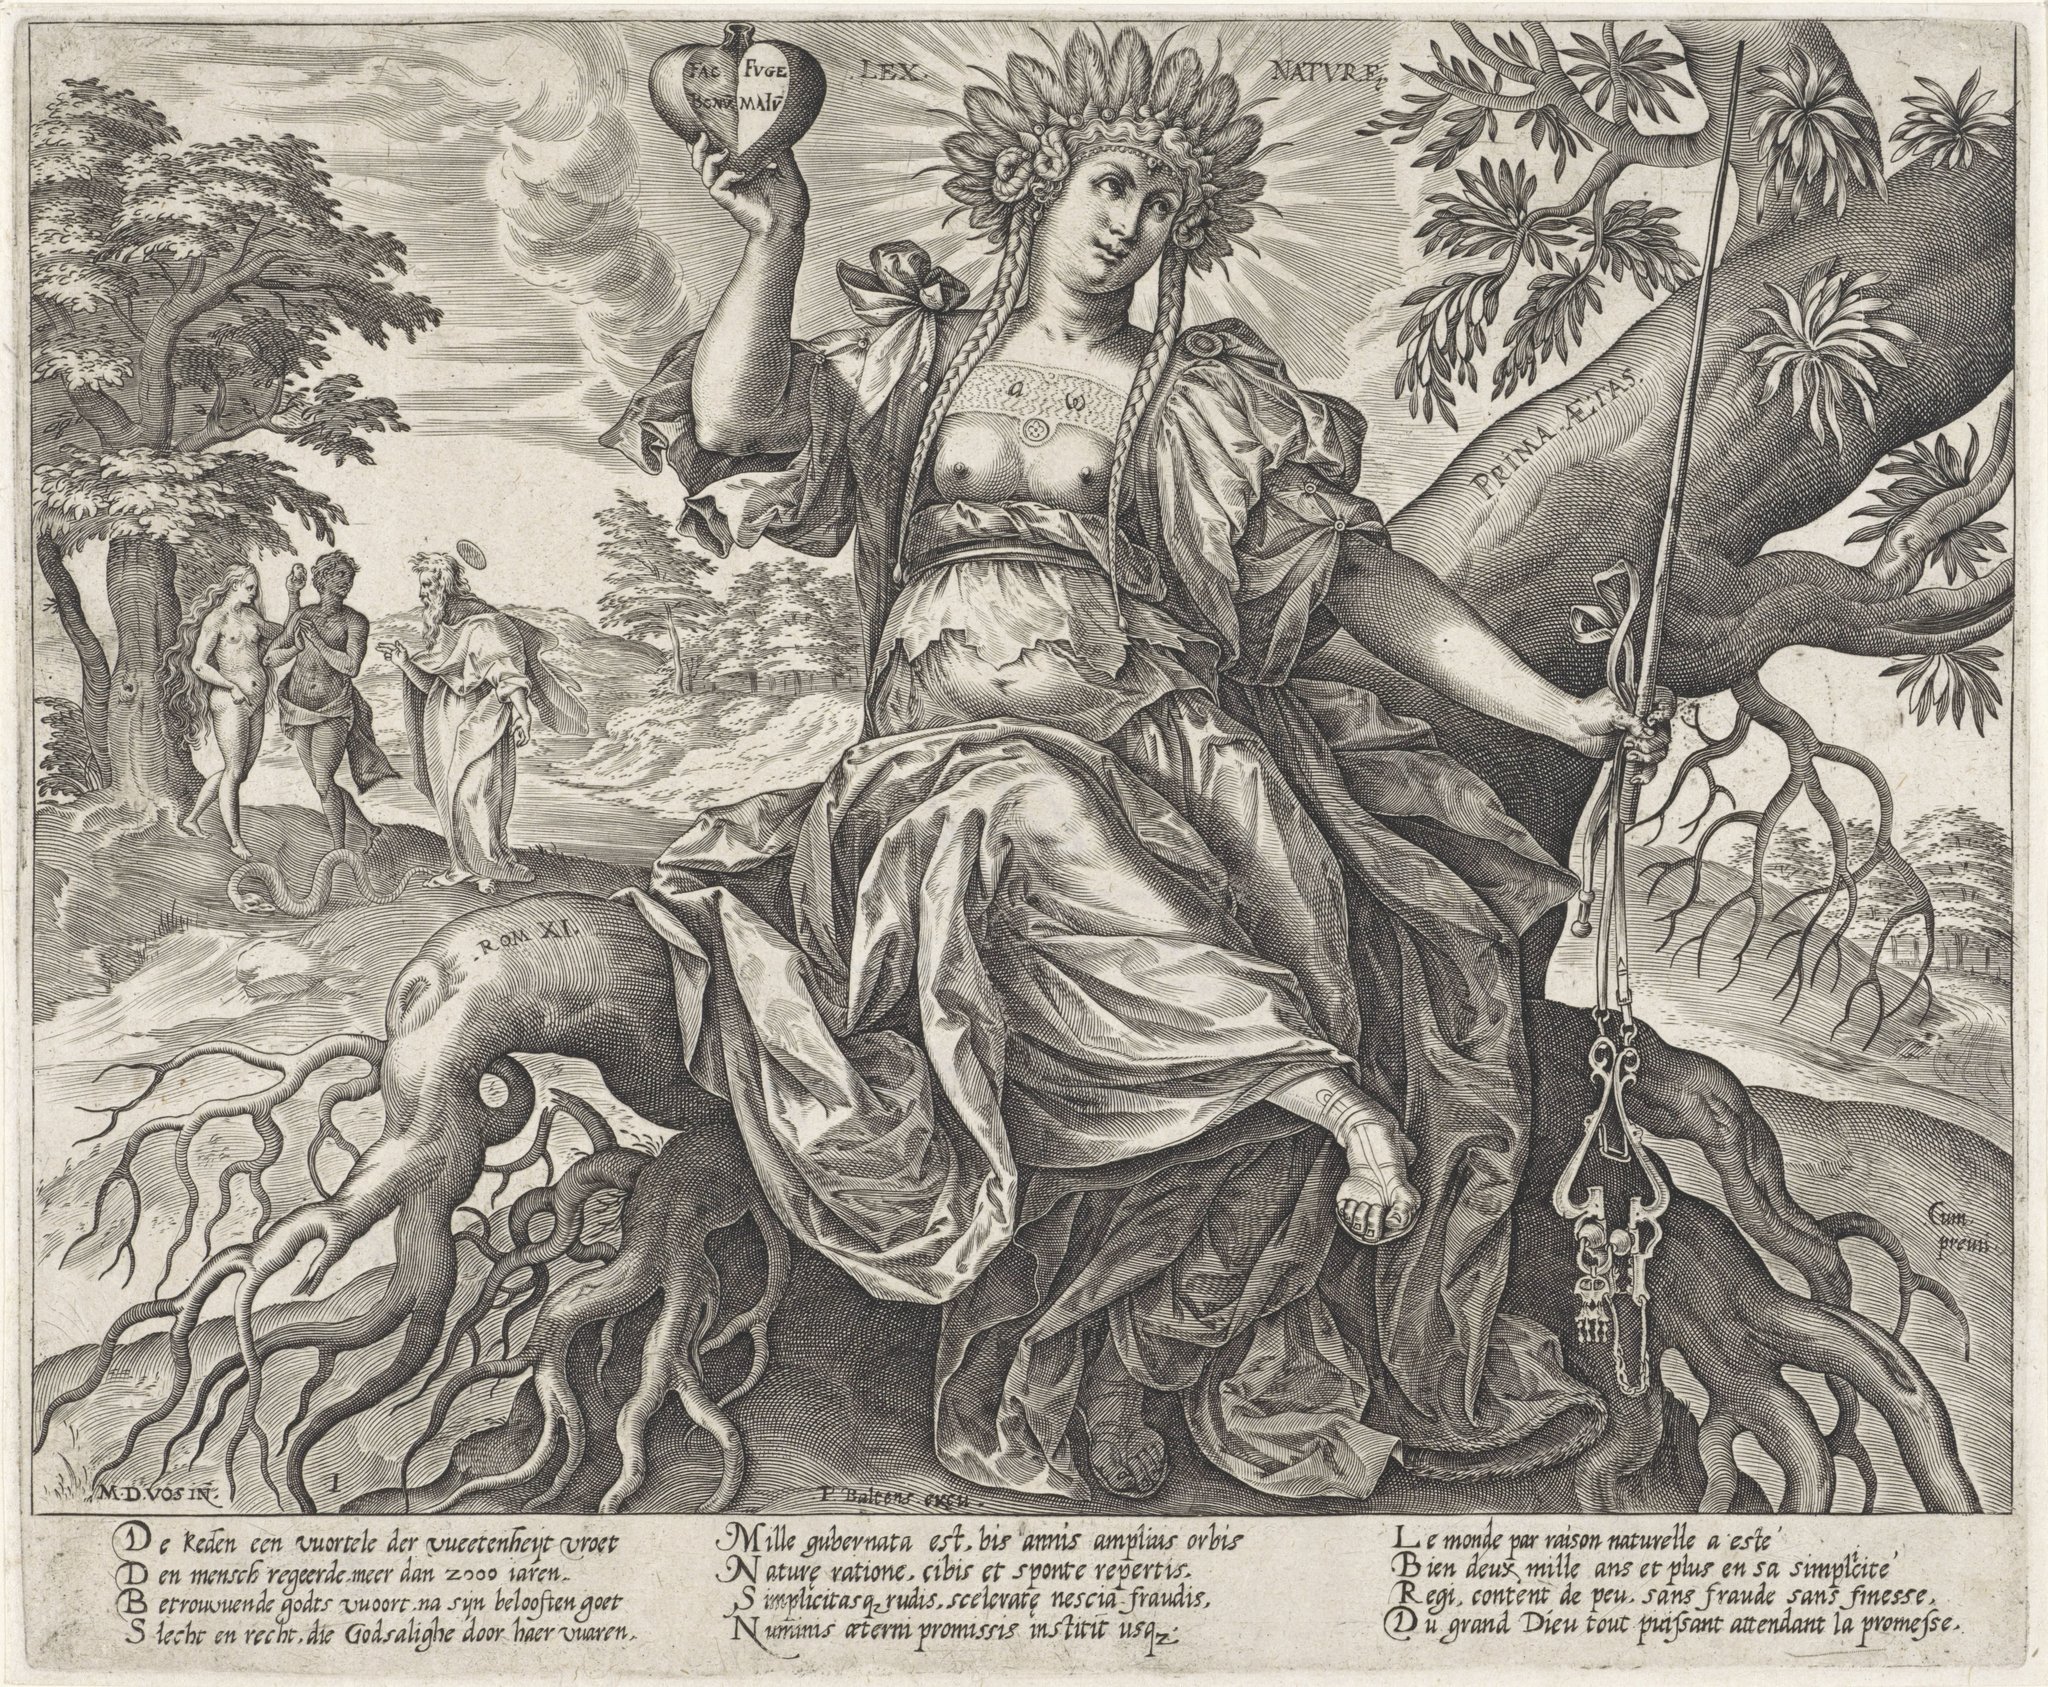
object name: print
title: De Gouden Eeuw: de wet van de natuur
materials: paper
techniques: engraving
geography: antwerp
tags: symbols and allegories of law; 'legge', 'legge civile' (ripa), expulsion of adam and eve from paradise (genesis 3:22-24), the golden age, 'aetas aurea'; men live happily, gathering fruits under the reign of saturn, bit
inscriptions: collector's mark: Lugt 2228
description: De vrouwelijke personificatie van de Wet van de Natuur (Lex Nature) zit op een ontwortelde boom. In haar ene hand houdt ze een hart, in de andere een bit en een zweep. Op de achtergrond bestraft God de Vader Adam en Eva door hen uit het paradijs te verbannen. In de marge een vierregelig onderschrift in het Nederlands, het Latijn en het Frans.